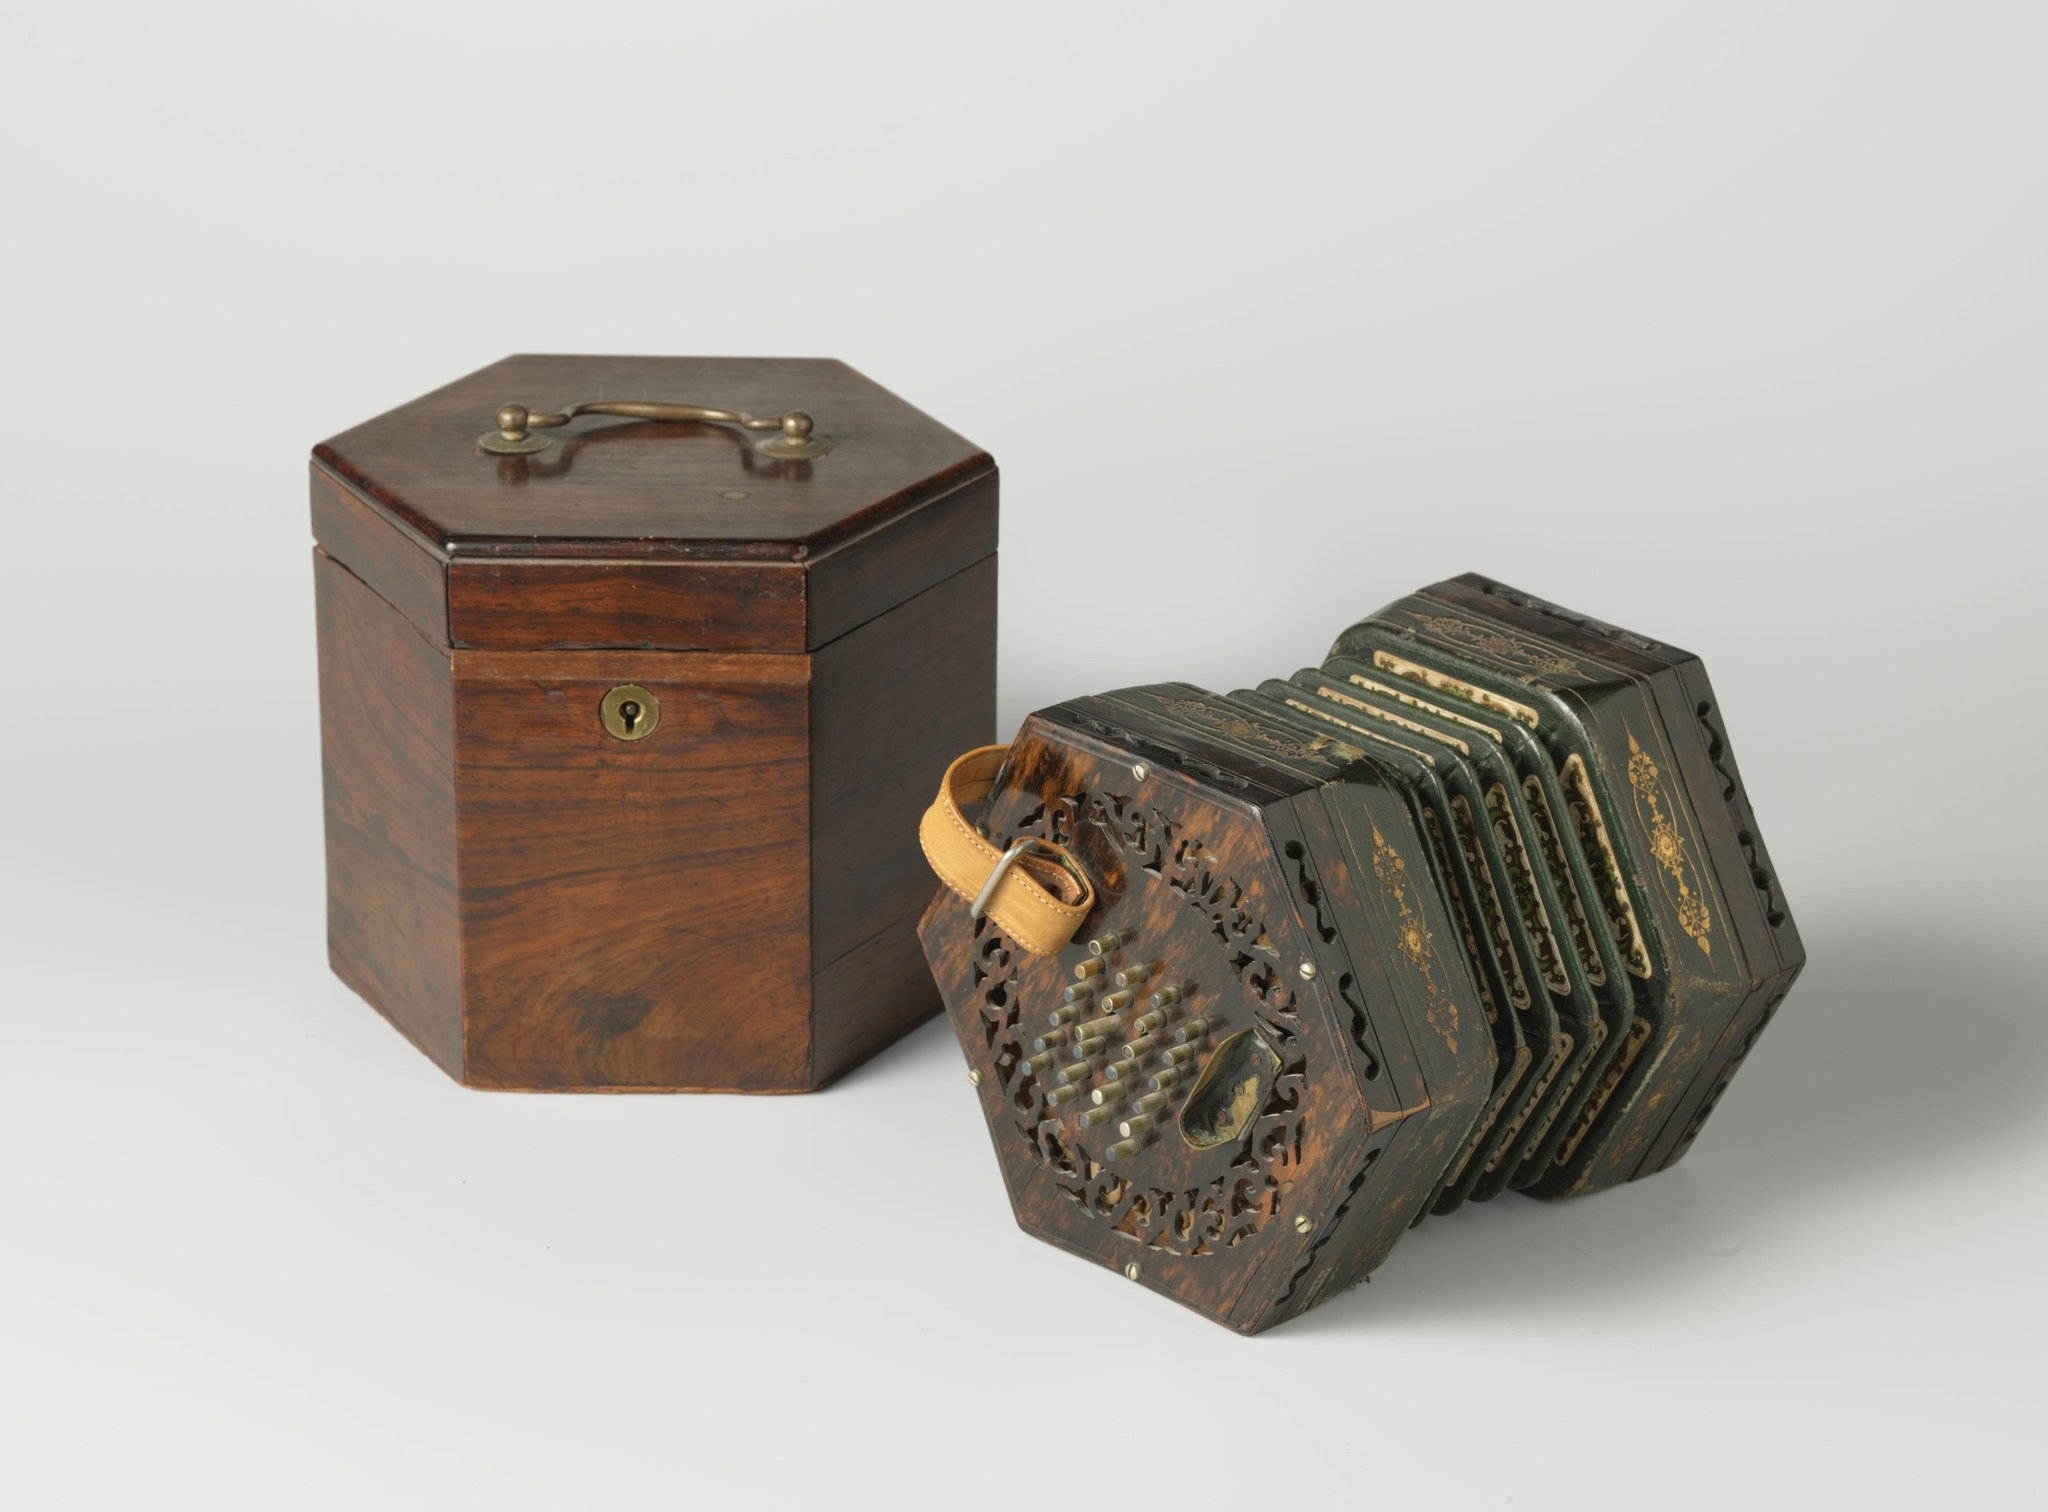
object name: concertina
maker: Anonymous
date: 1850-1860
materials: leather, metal, wood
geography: europe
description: Rijk versierde concertina, ongesigneerd maar in stijl en afwerking identiek aan gesigneerde instrumenten van Charles Wheatstone. Mechaniek en decoraties lijken in grote lijnen in originele staat. De concertina wordt bewaard in een bijpassende, maar iets gehavende, houten doos.